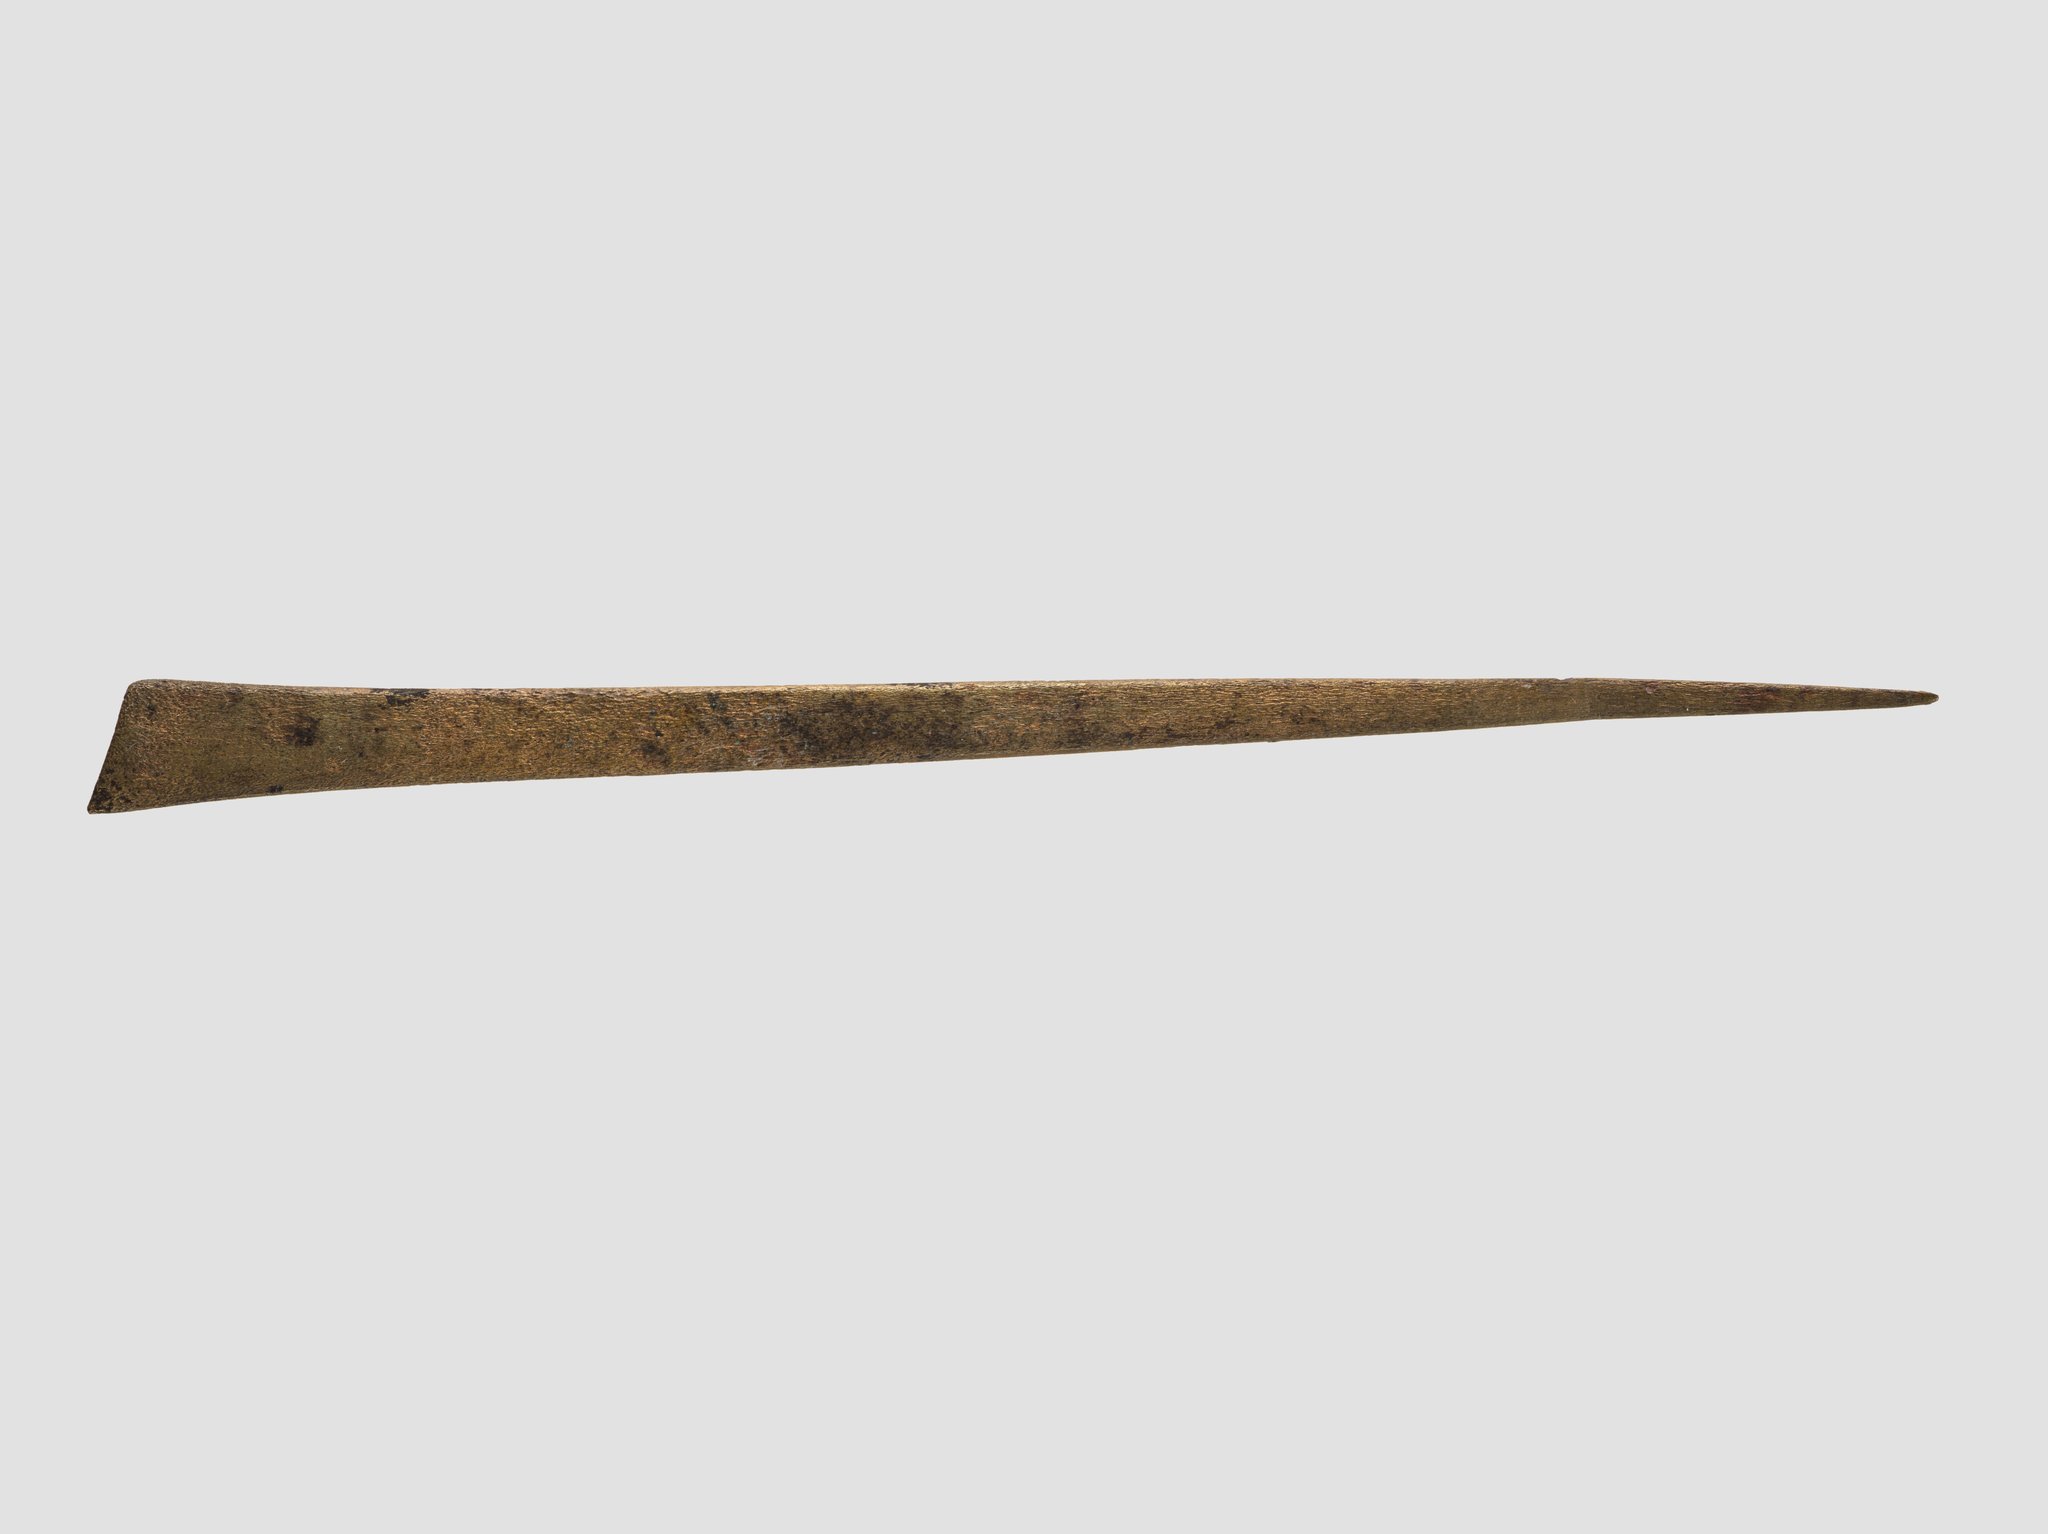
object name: pin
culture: sasanian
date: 201-700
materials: bronze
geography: iran